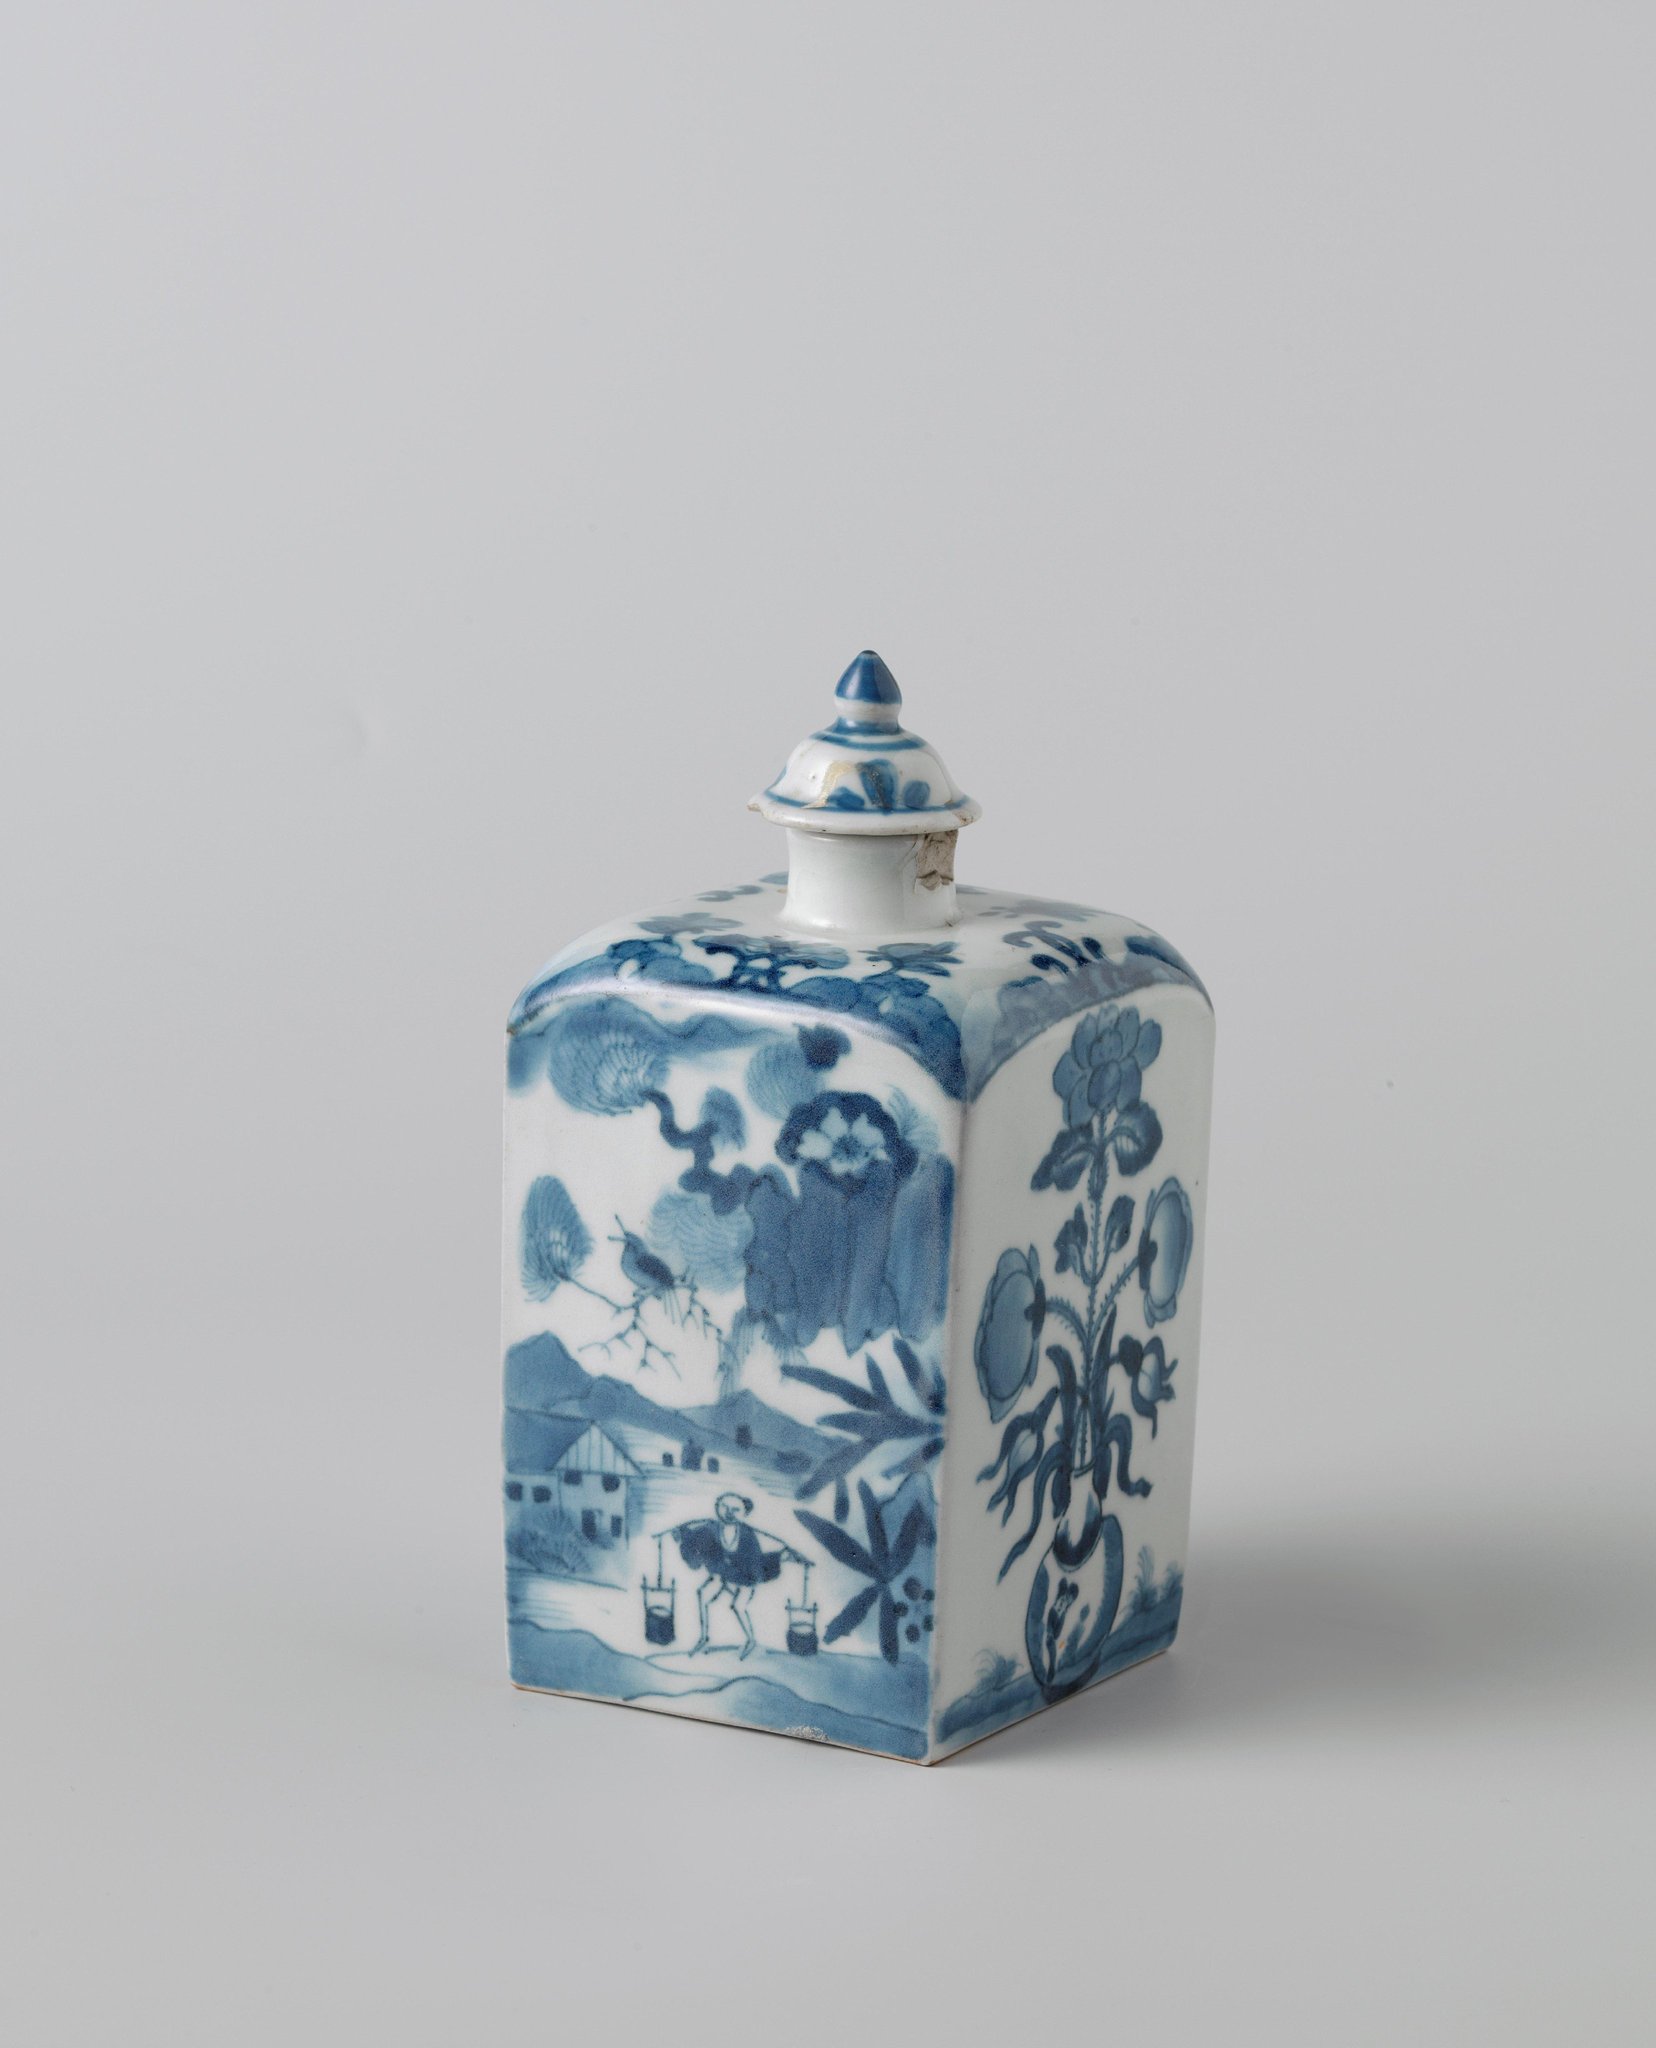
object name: bottle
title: Square bottle with figures in a landscape, a flower vase and a flowering plant near a rock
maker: Anonymous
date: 1660-1680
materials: cobalt, glaze, paint, porcelain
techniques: firing, forming, vitrification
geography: japan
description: These two square bottles were made to order, probably after examples of Delft pottery. The landscape is painted in a mixed style: the figure carrying two buckets is Japanese, while the houses look European.